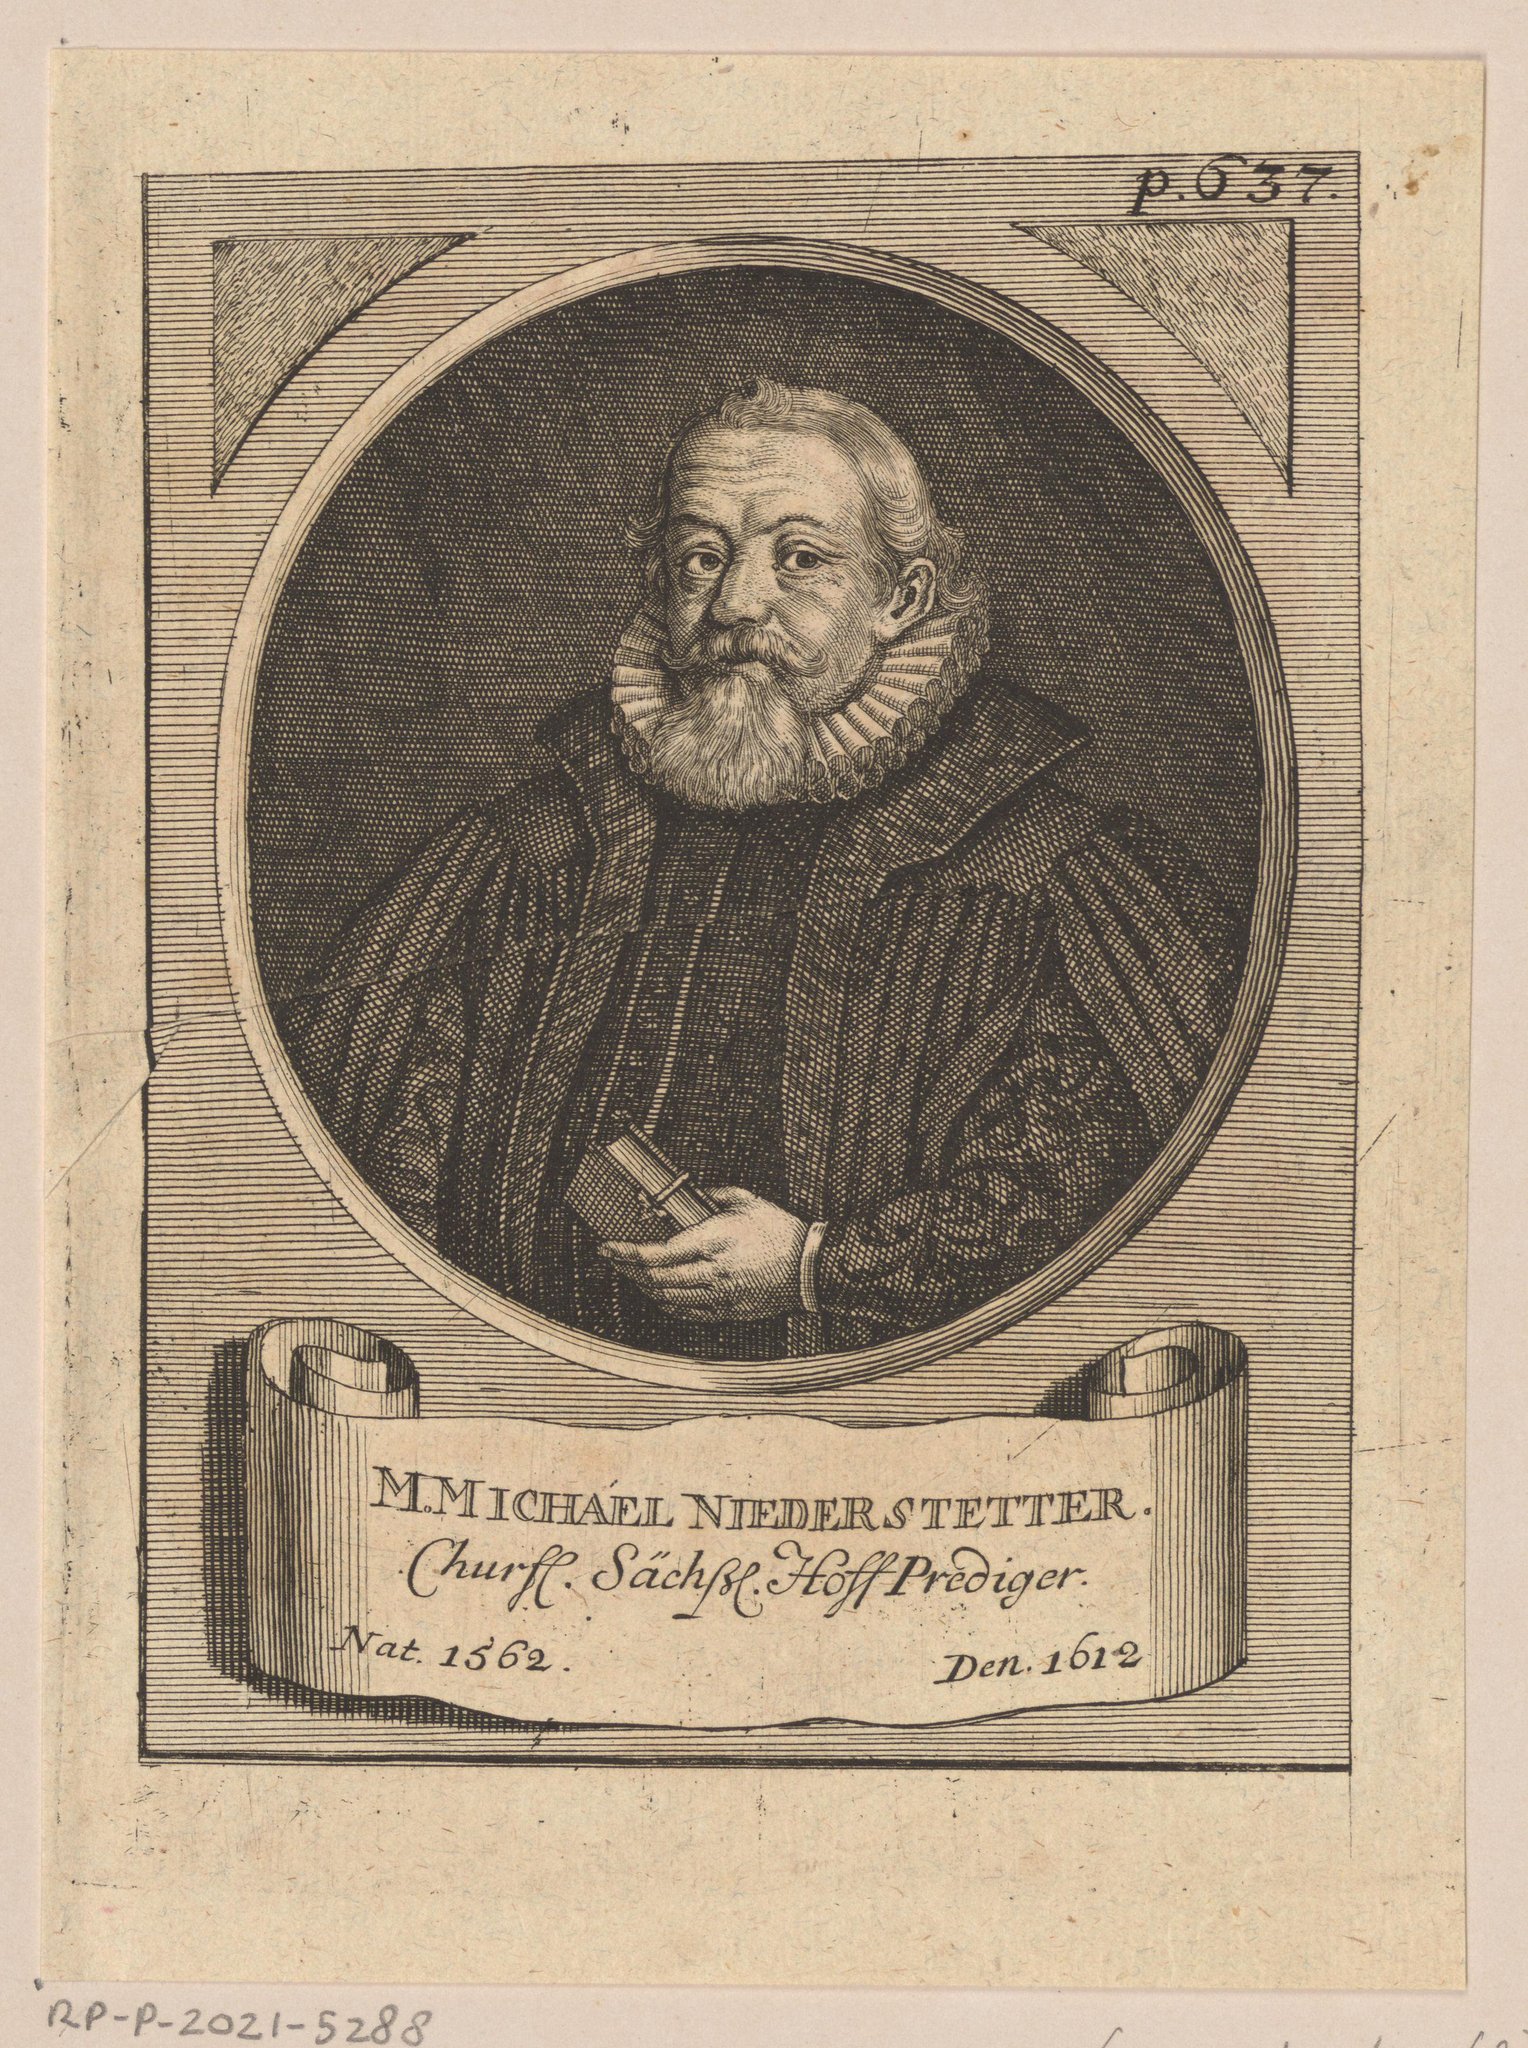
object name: print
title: Portret van Michael Niederstetter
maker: Anonymous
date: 1730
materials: paper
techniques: engraving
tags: historical persons, book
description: Prent waarschijnlijk uit: Gleich, Johann Andreas. Annales ecclesiastici oder Gründliche Nachrichten der Reformations-Historie (...). Dresden en Leipzig: Raphael Christian Saueressig, 1730.